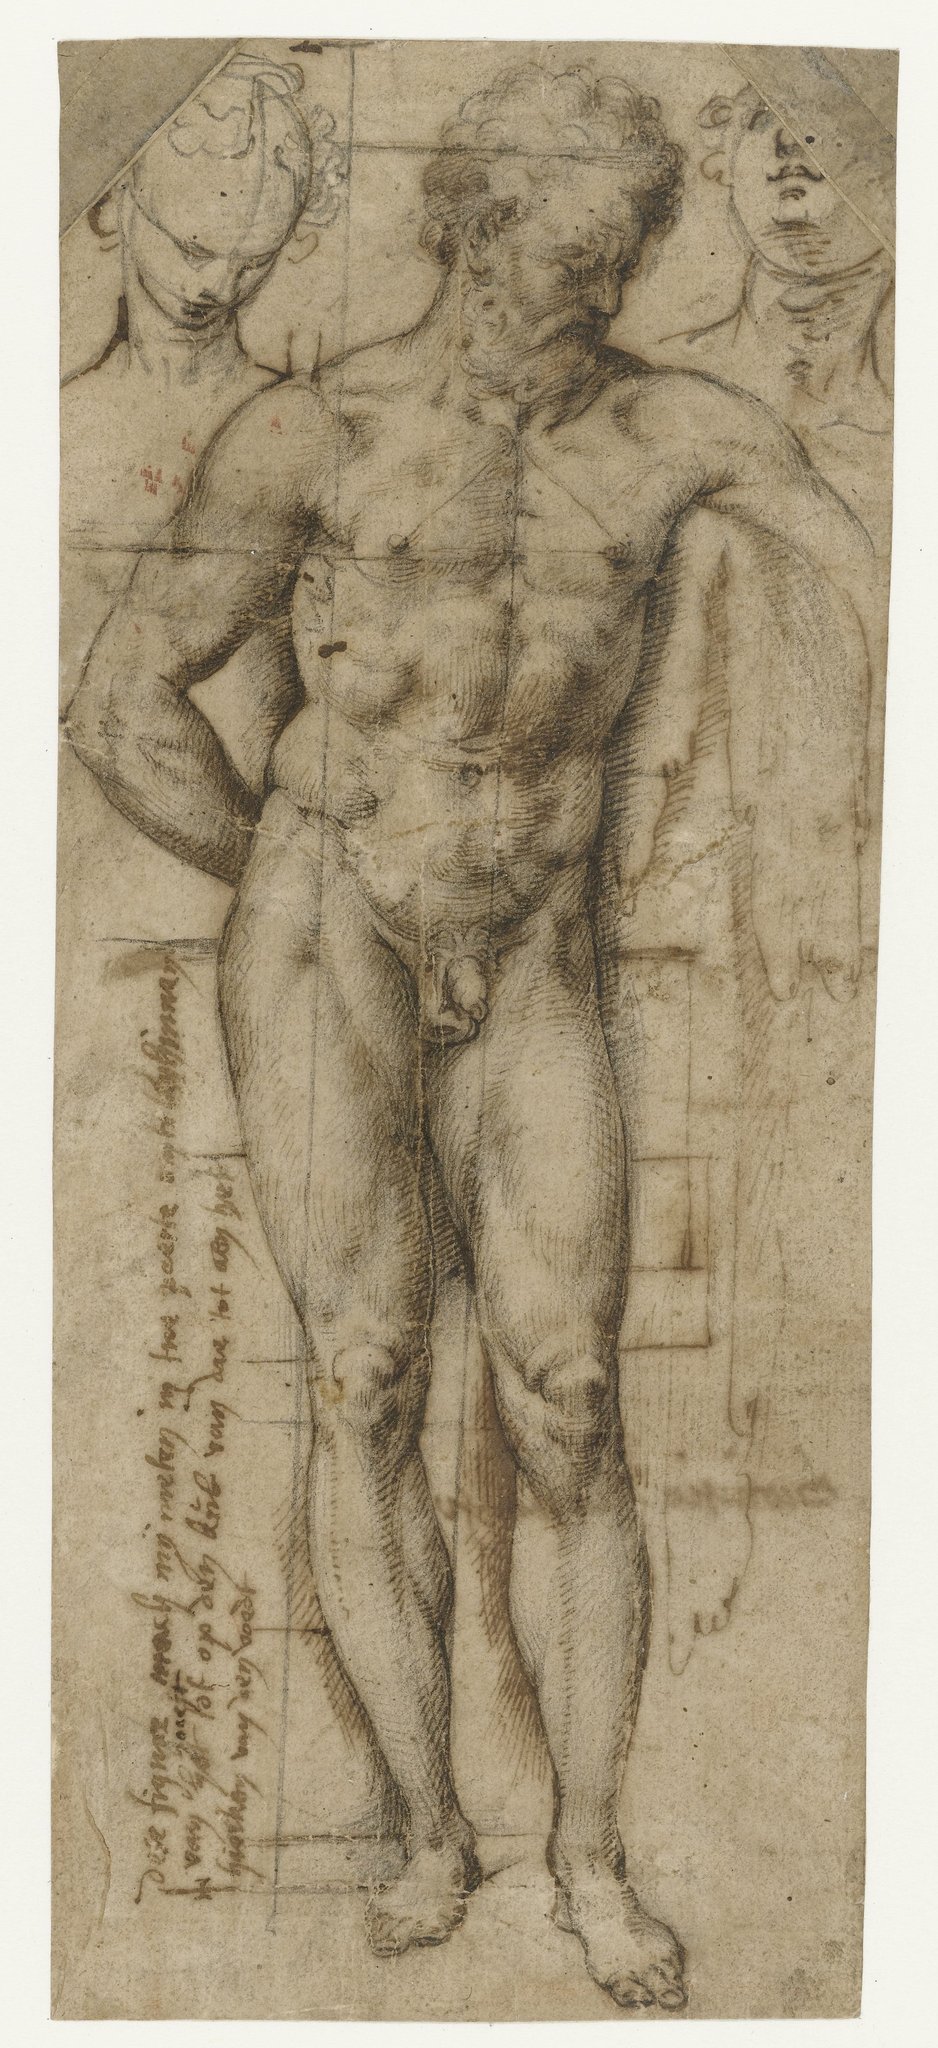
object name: drawing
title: Studie van een naakte man (Hercules?) en twee hoofden van vrouwen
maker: denys calvaert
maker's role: draughtsman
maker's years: 1540-1619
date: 1573-1576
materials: chalk, ink, paper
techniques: pen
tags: 'contrapposto', 'standbein und spielbein'